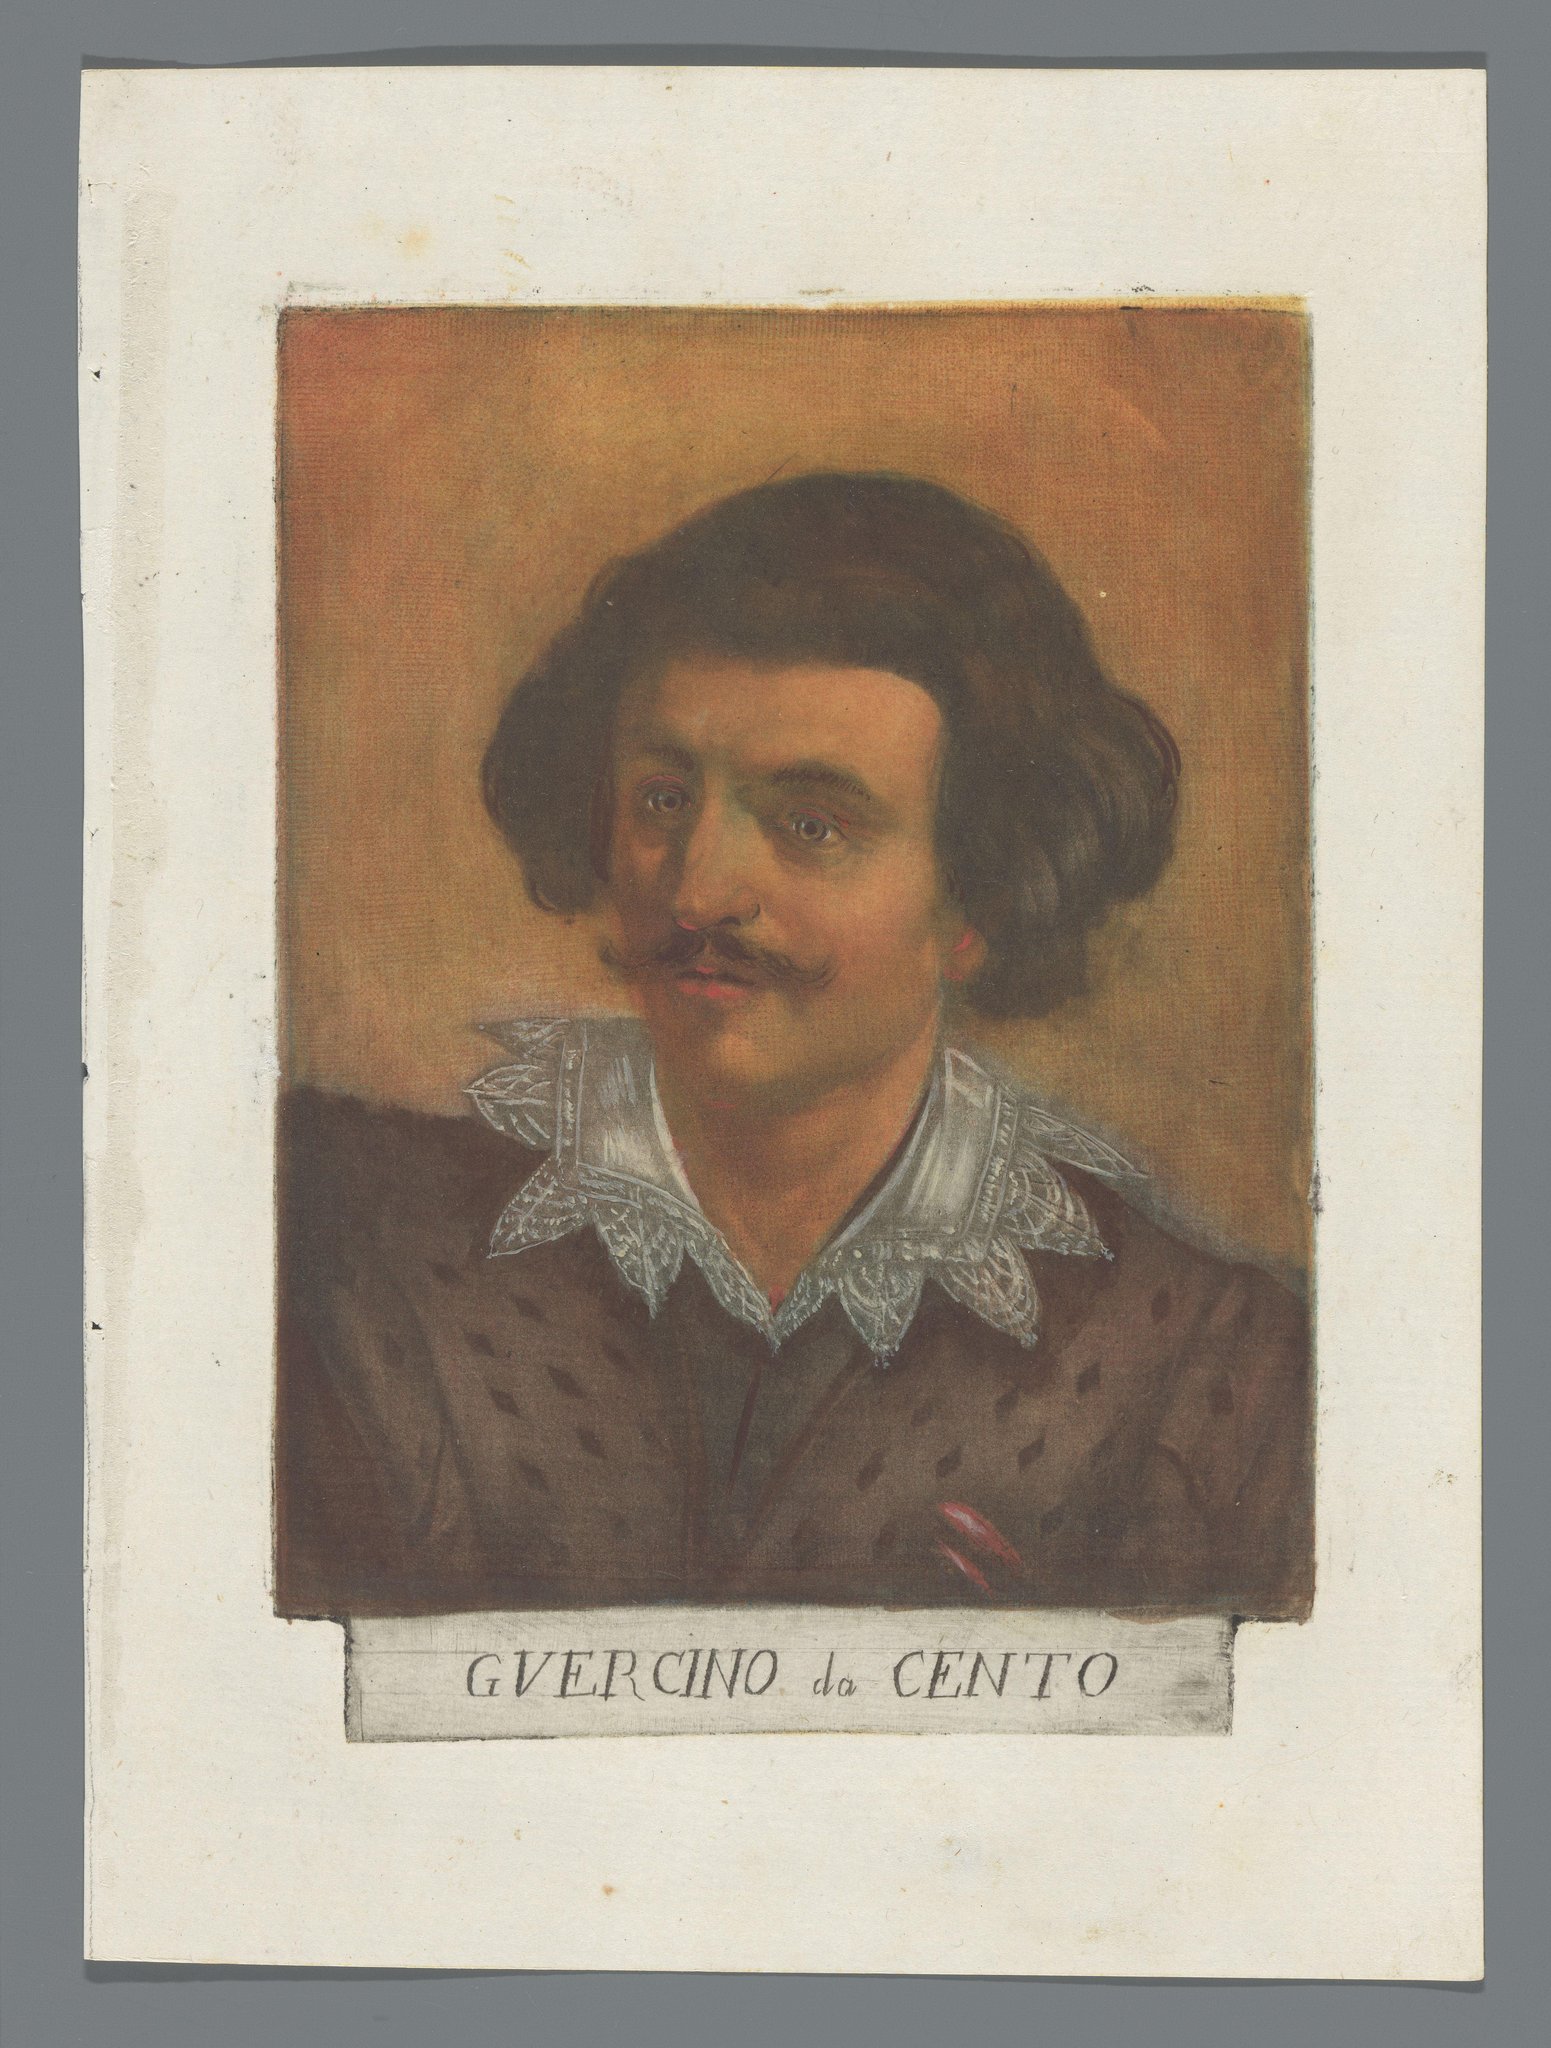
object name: print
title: Guercino da Cento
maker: carlo lasinio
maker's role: painter, print maker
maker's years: 1759-1838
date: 1789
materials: gouache, paper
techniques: color mezzotint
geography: florence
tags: painter, draughtsman, guercino, historical persons, portrait, self-portrait of painter, portrait, self-portrait of artist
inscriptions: inscription:, collector's mark: Lugt 2228, number: ‘22’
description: Een prent uit een groep van veertig kleurendrukken met kunstenaarsportretten, gebaseerd op de collectie geschilderde zelfportretten van kunstenaars verzameld door de Medici in Florence. De groep maakt deel uit van het grote werk van Lasinio ‘Gli Autoritratti della Real Galleria di Firenze’, uitgegeven in 1789 met omstreeks 350 kunstenaarsportretten. Van deze uitgave is tot nog toe is geen compleet exemplaar bekend. In de inspringende marges onderaan de prenten zijn de namen van de kunstenaars aangebracht en soms hun levensdata en de plaats van geboorte en sterven en een enkele maal de signatuur van Lasinio en dat van de drukker Labrelis. Getuige de bindgaatjes en lijmresten moeten de prenten ingebonden zijn geweest in een album. De meeste prenten zijn verso voorzien van nummers in potlood, met als laagste nummer 2 en hoogste 93. Tevens zijn er verso Italiaanse opschriften in pen aangebracht met de levensdata van de kunstenaars en de school waartoe zij worden gerekend. Deze opschriften zijn vrijwel alle deels afgesneden. Elf prenten zijn niet genummerd en niet voorzien van opschriften. Deze laatste elf zijn alle gedrukt op blauw papier.